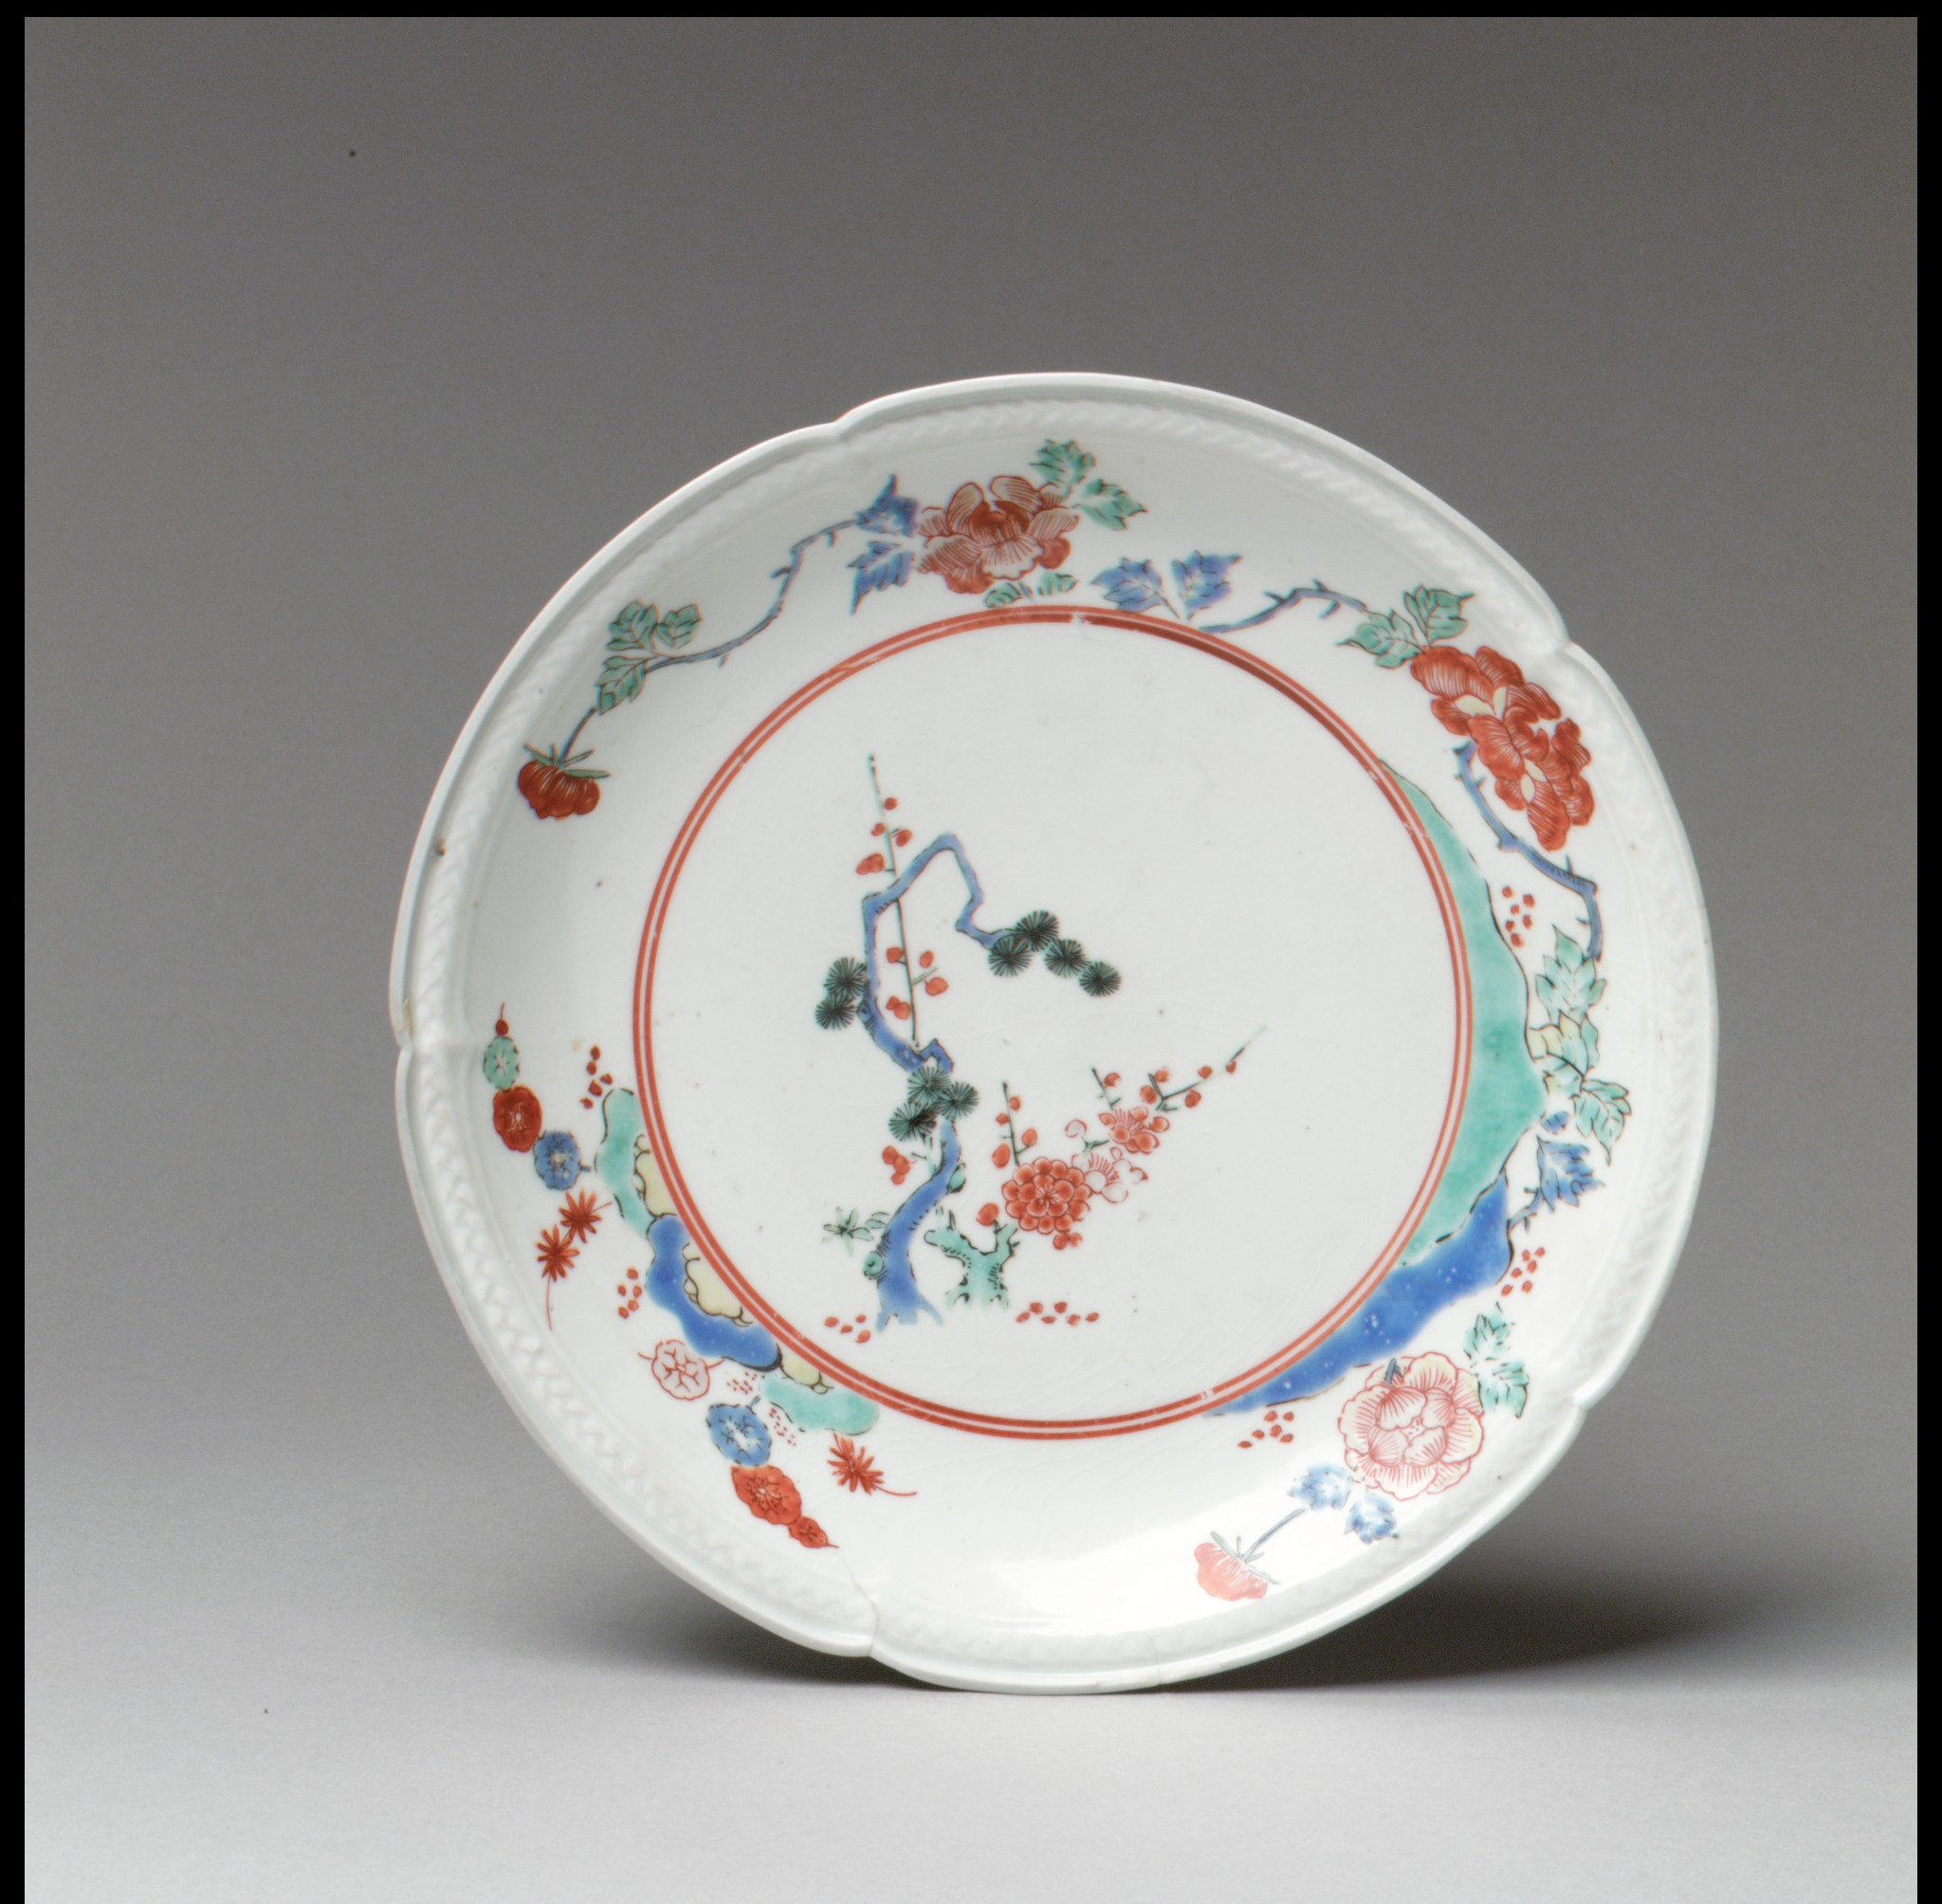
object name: dish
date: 1734-1766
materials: hard paste porcelain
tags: flowers